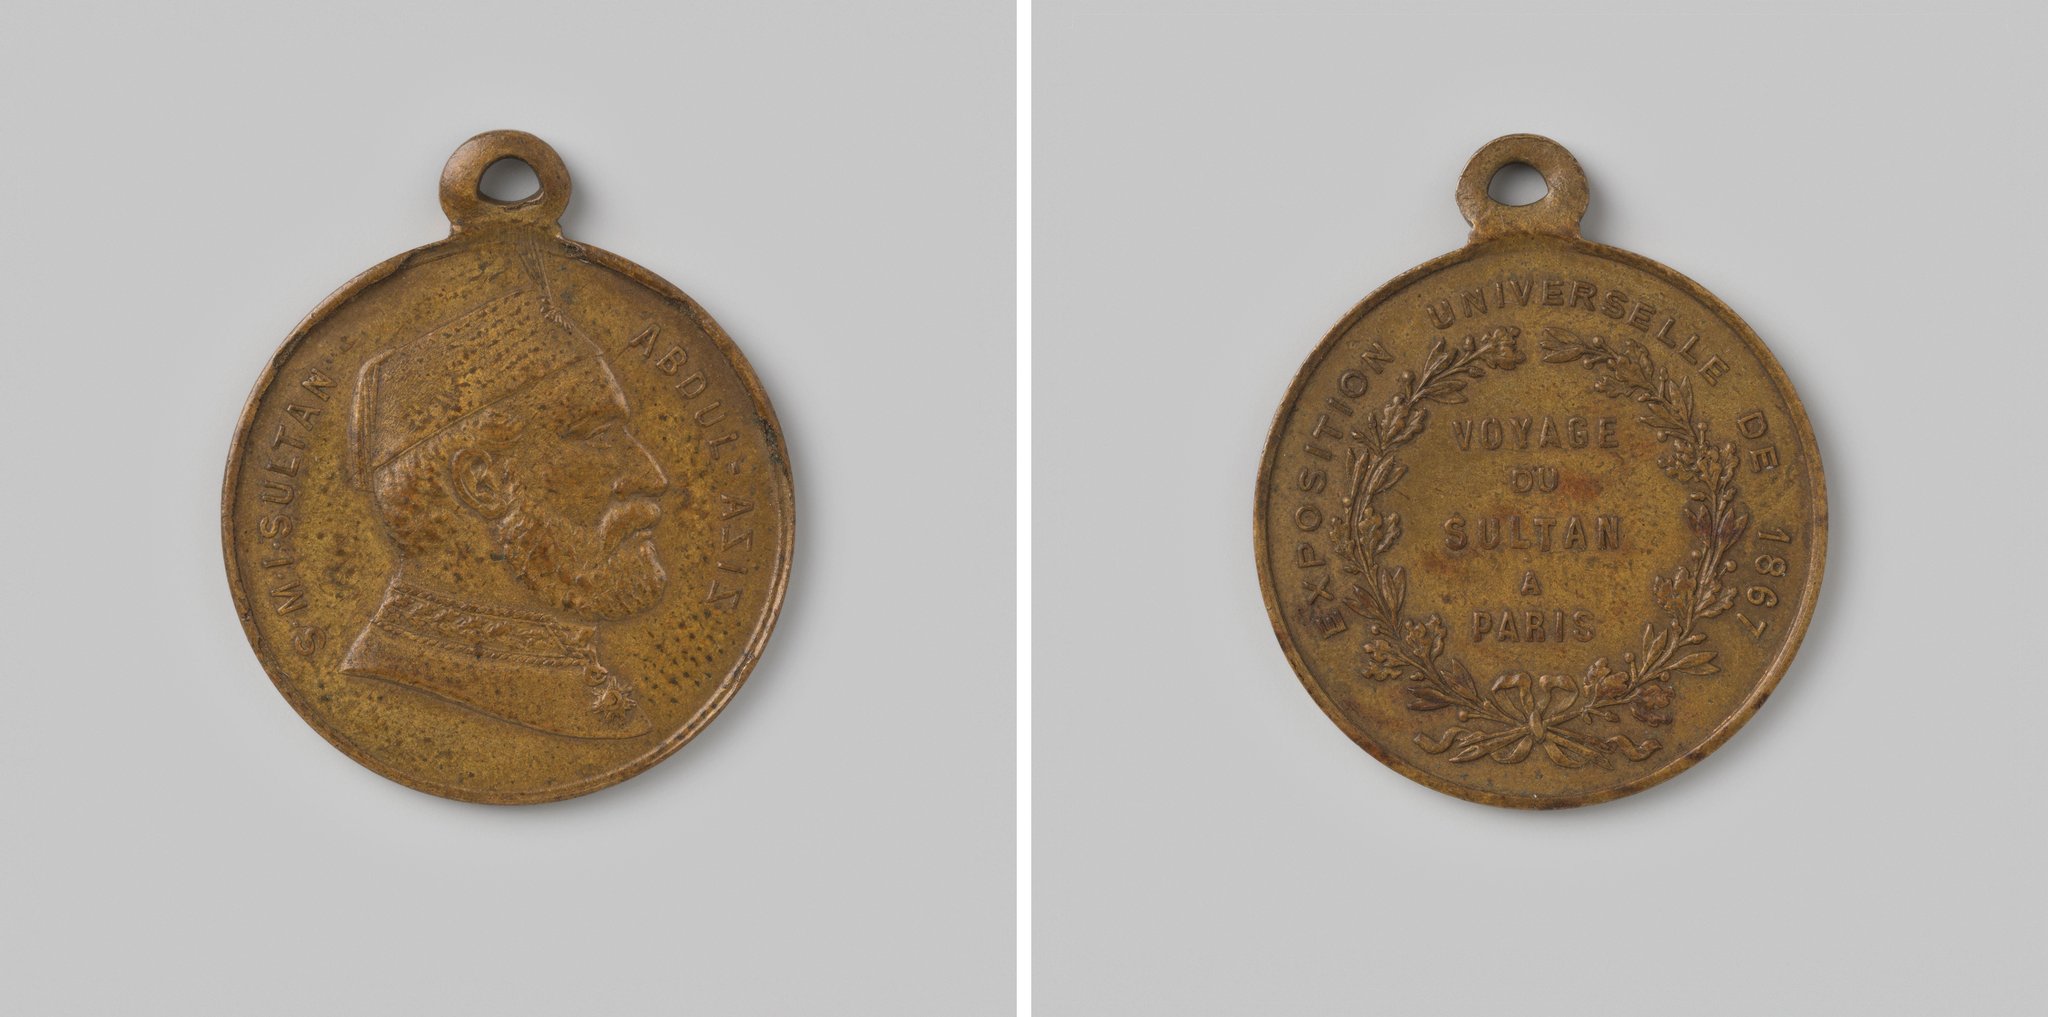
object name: history medal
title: Bezoek van Sultan Abdul Aziz aan de Wereldtentoonstelling te Parijs 1867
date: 1867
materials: brass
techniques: striking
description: Messing penning met draagoog, op de voorzijde het borstbeeld van de Sultan naar rechts met omschrift, op de keerzijde vijf regels tekst tussen samengestrikte lauwer- en eikentakken, met omschrift.